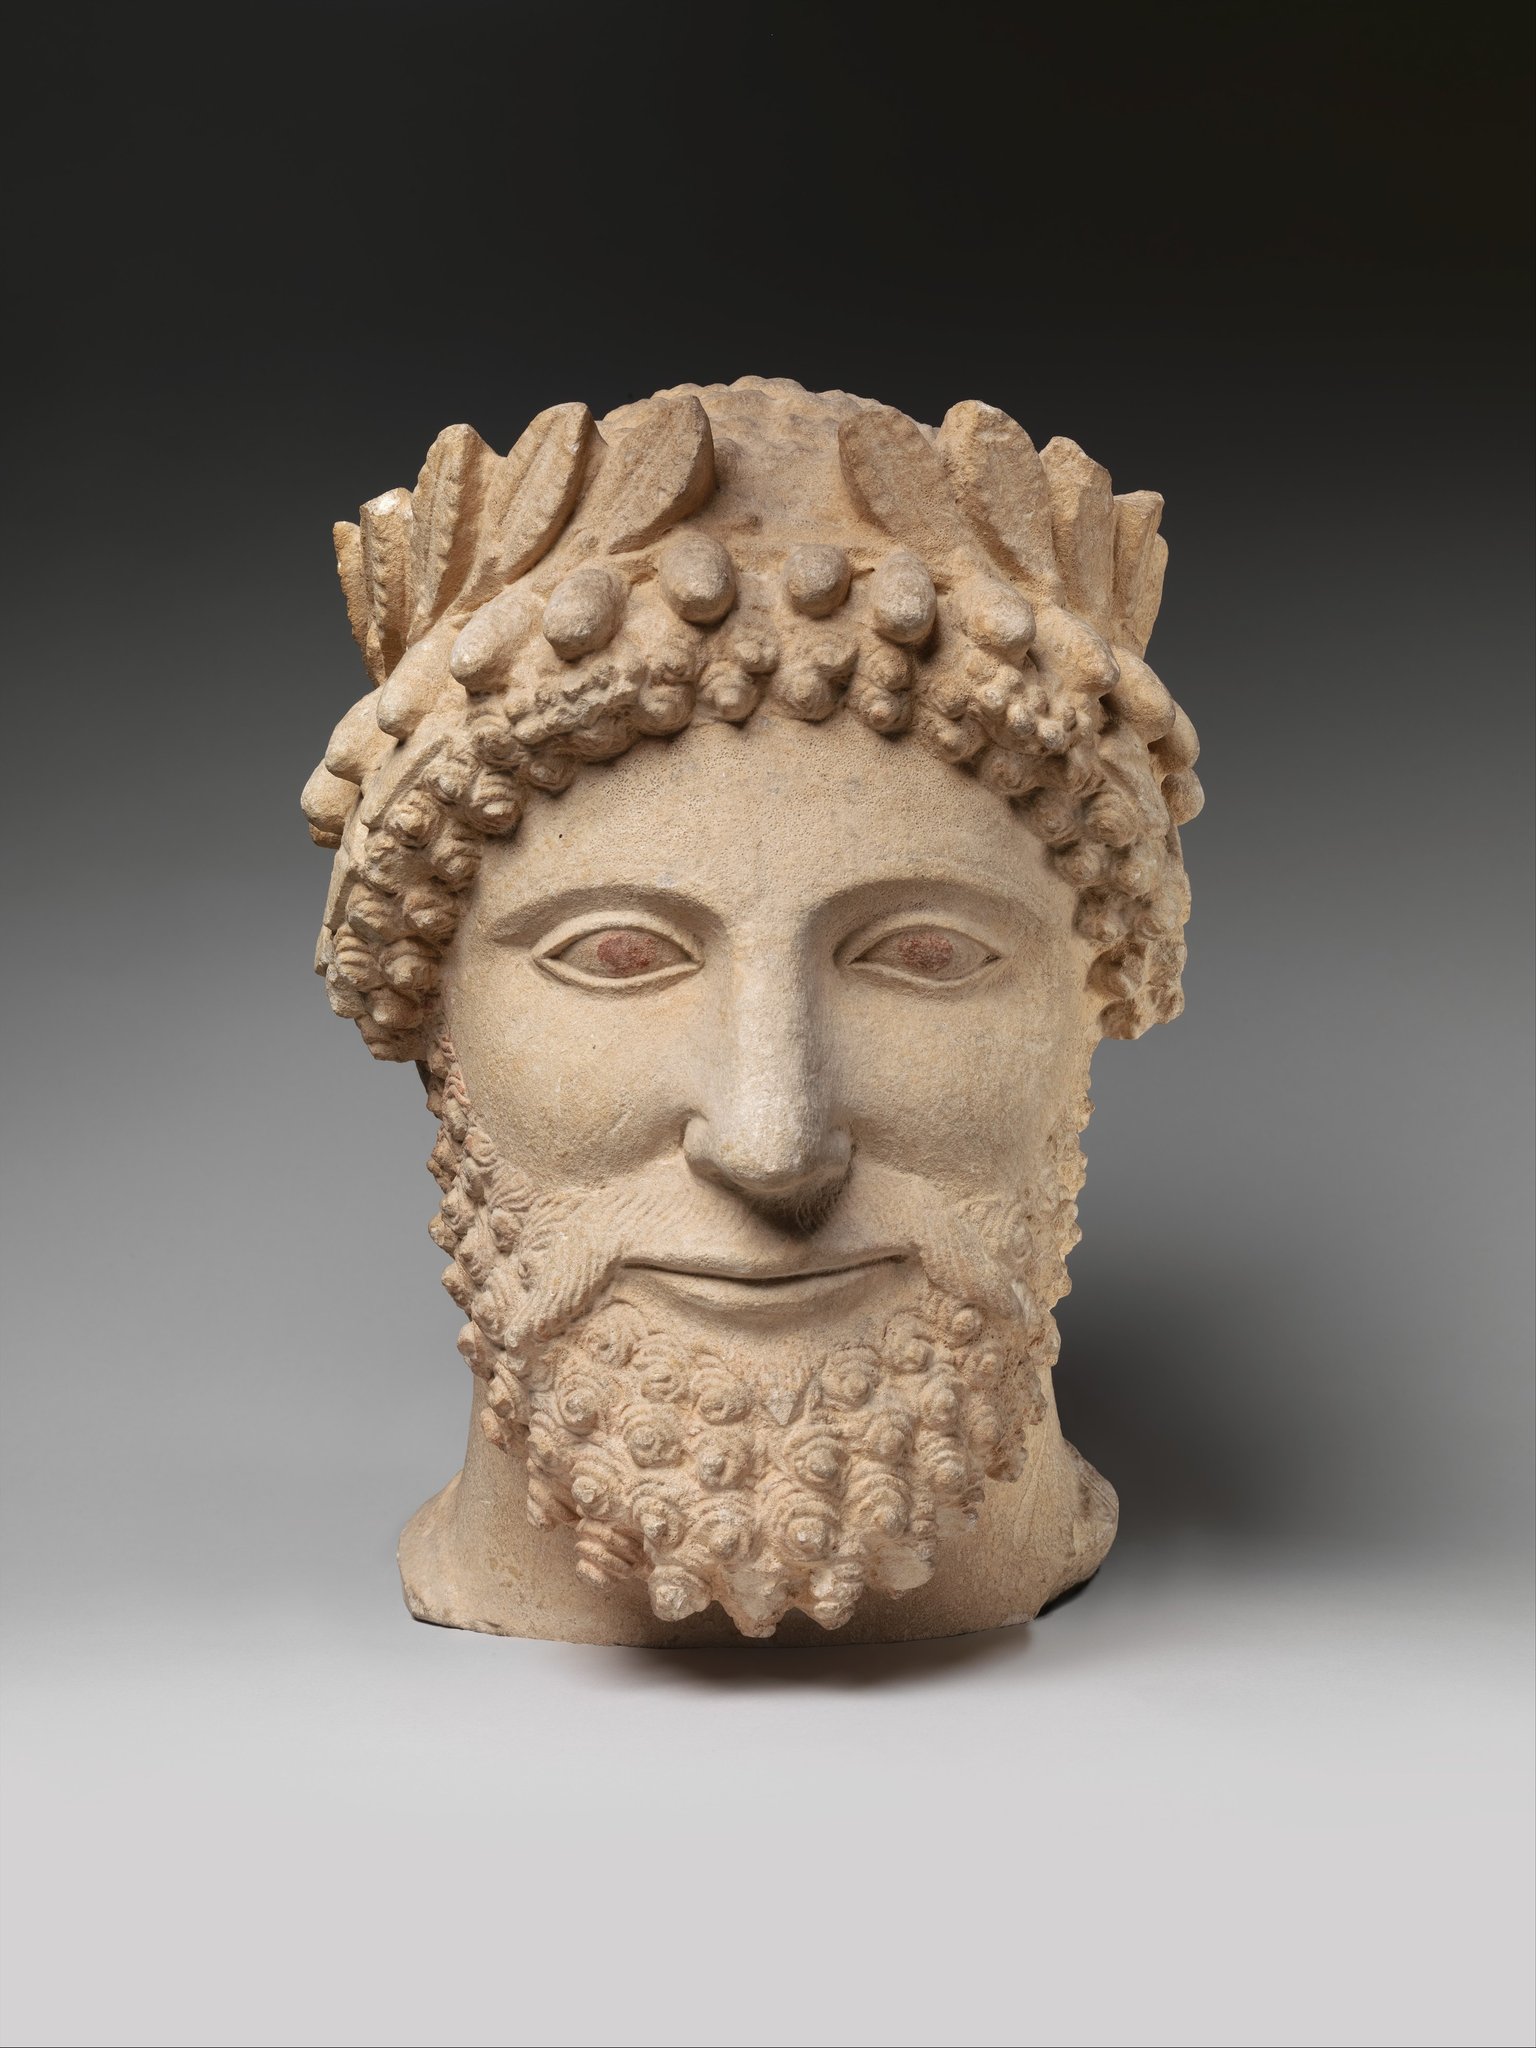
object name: male head, beardless, wearing a wreath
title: Limestone head of a bearded man wearing a wreath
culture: cypriot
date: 500-468 BCE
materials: limestone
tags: heads,men,leaves,wreaths